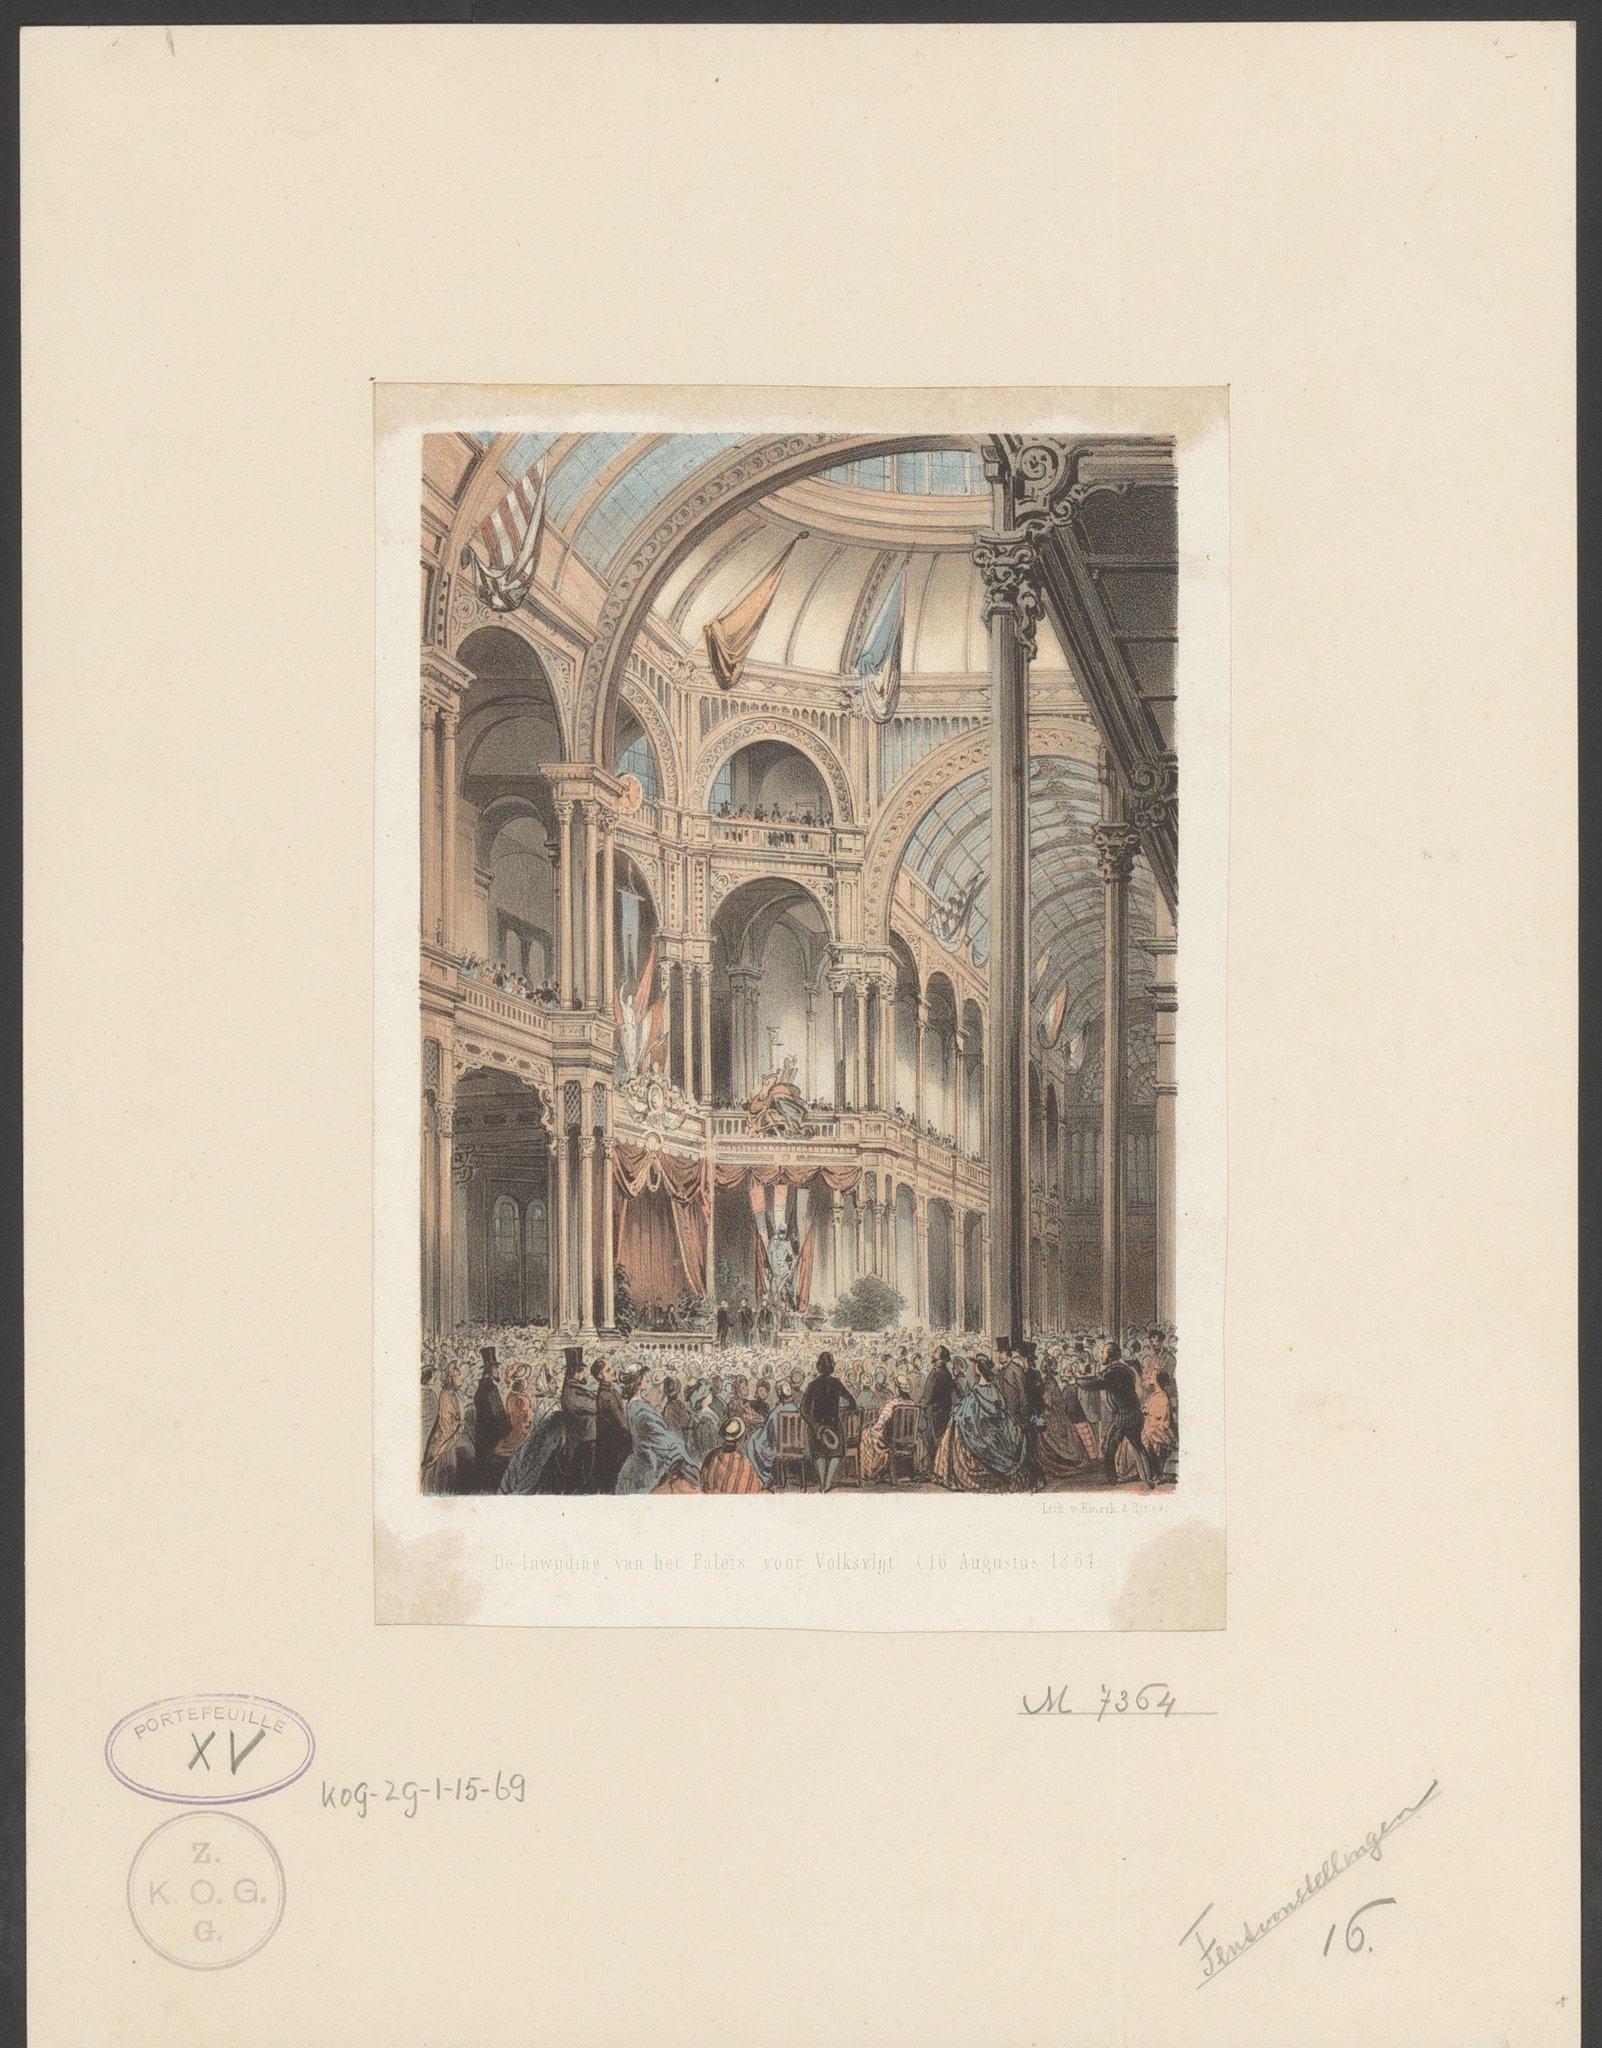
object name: print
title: De inwijding van het Paleis voor Volksvlijt (18 Augustus 1864)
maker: Anonymous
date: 1864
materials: paper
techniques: lithograph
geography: haarlem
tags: public festivities, festivities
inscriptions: stamp, collector's mark: Lugt 1641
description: Prent mogelijk uit: 't Paleis voor Volksvlijt te Amsterdam. De opening van het paleis. Amsterdam: Christiaan Andersen Spin, 1864.